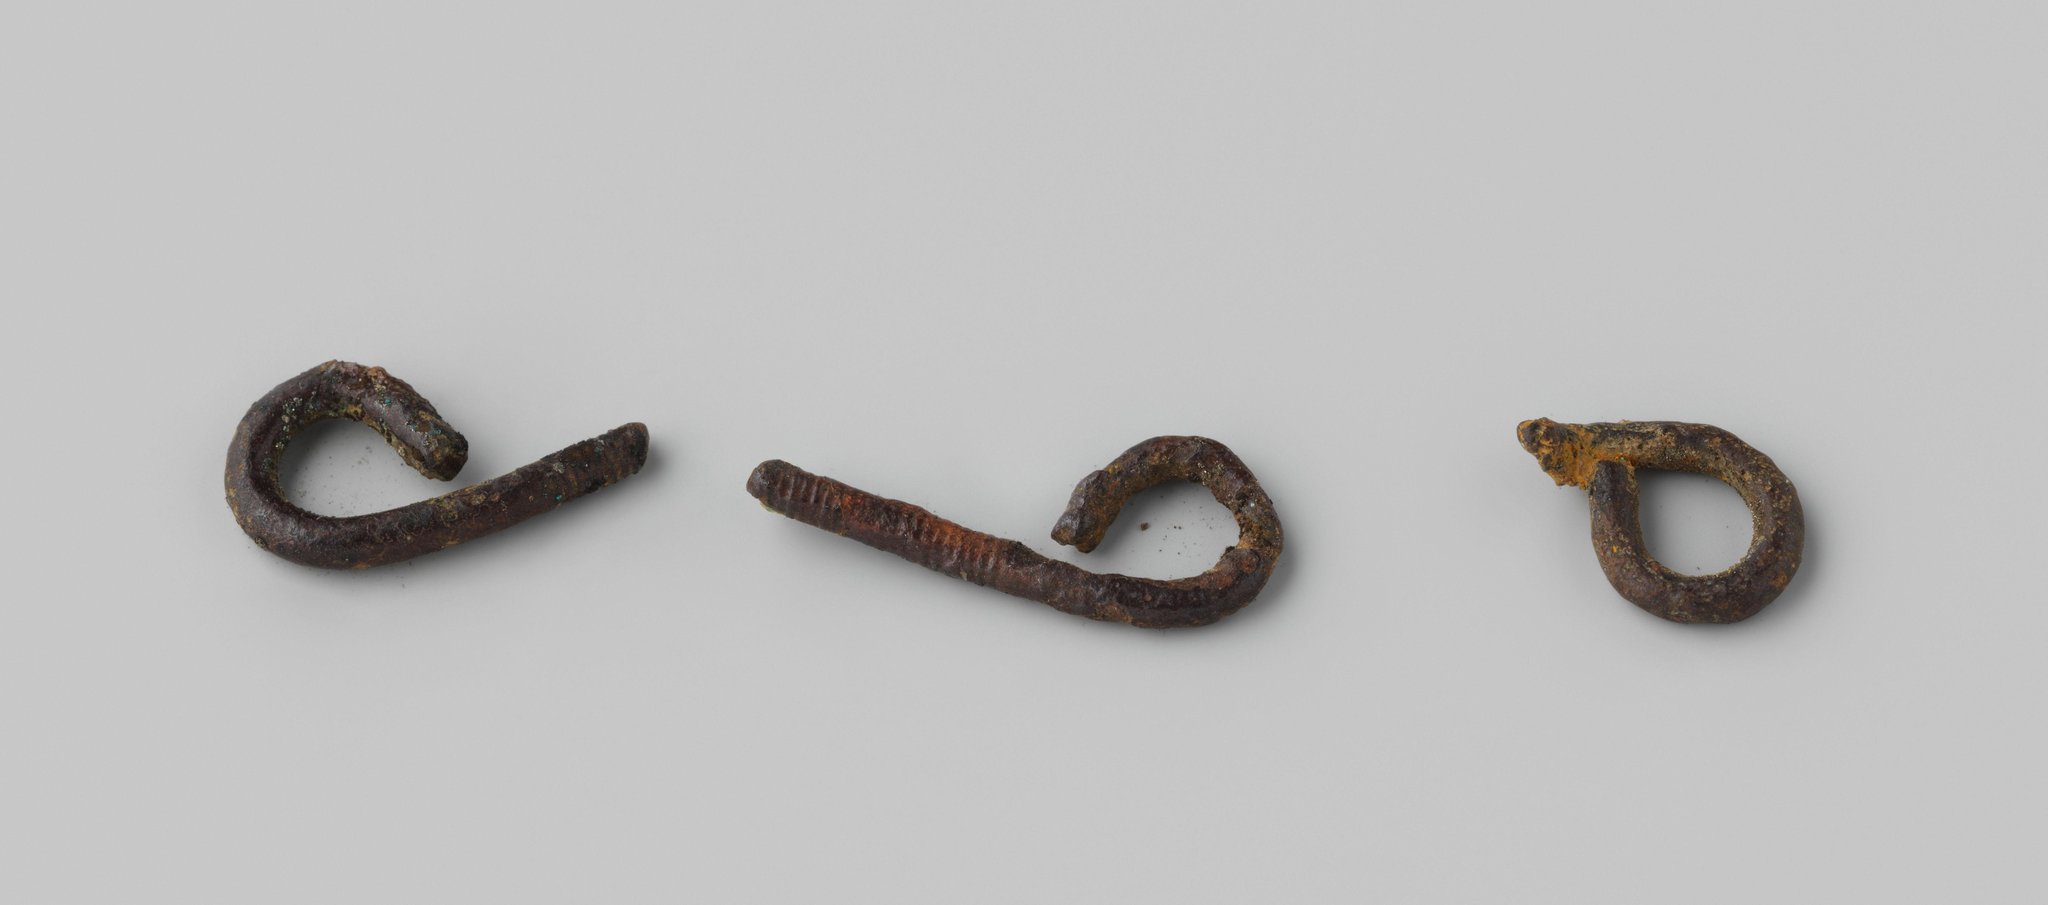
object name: screw eye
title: Schroefogen afkomstig uit het wrak van de Oost-Indiëvaarder Hollandia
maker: Anonymous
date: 1700-1743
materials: copper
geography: netherlands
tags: verenigde oostindische compagnie, hollandia (schip)